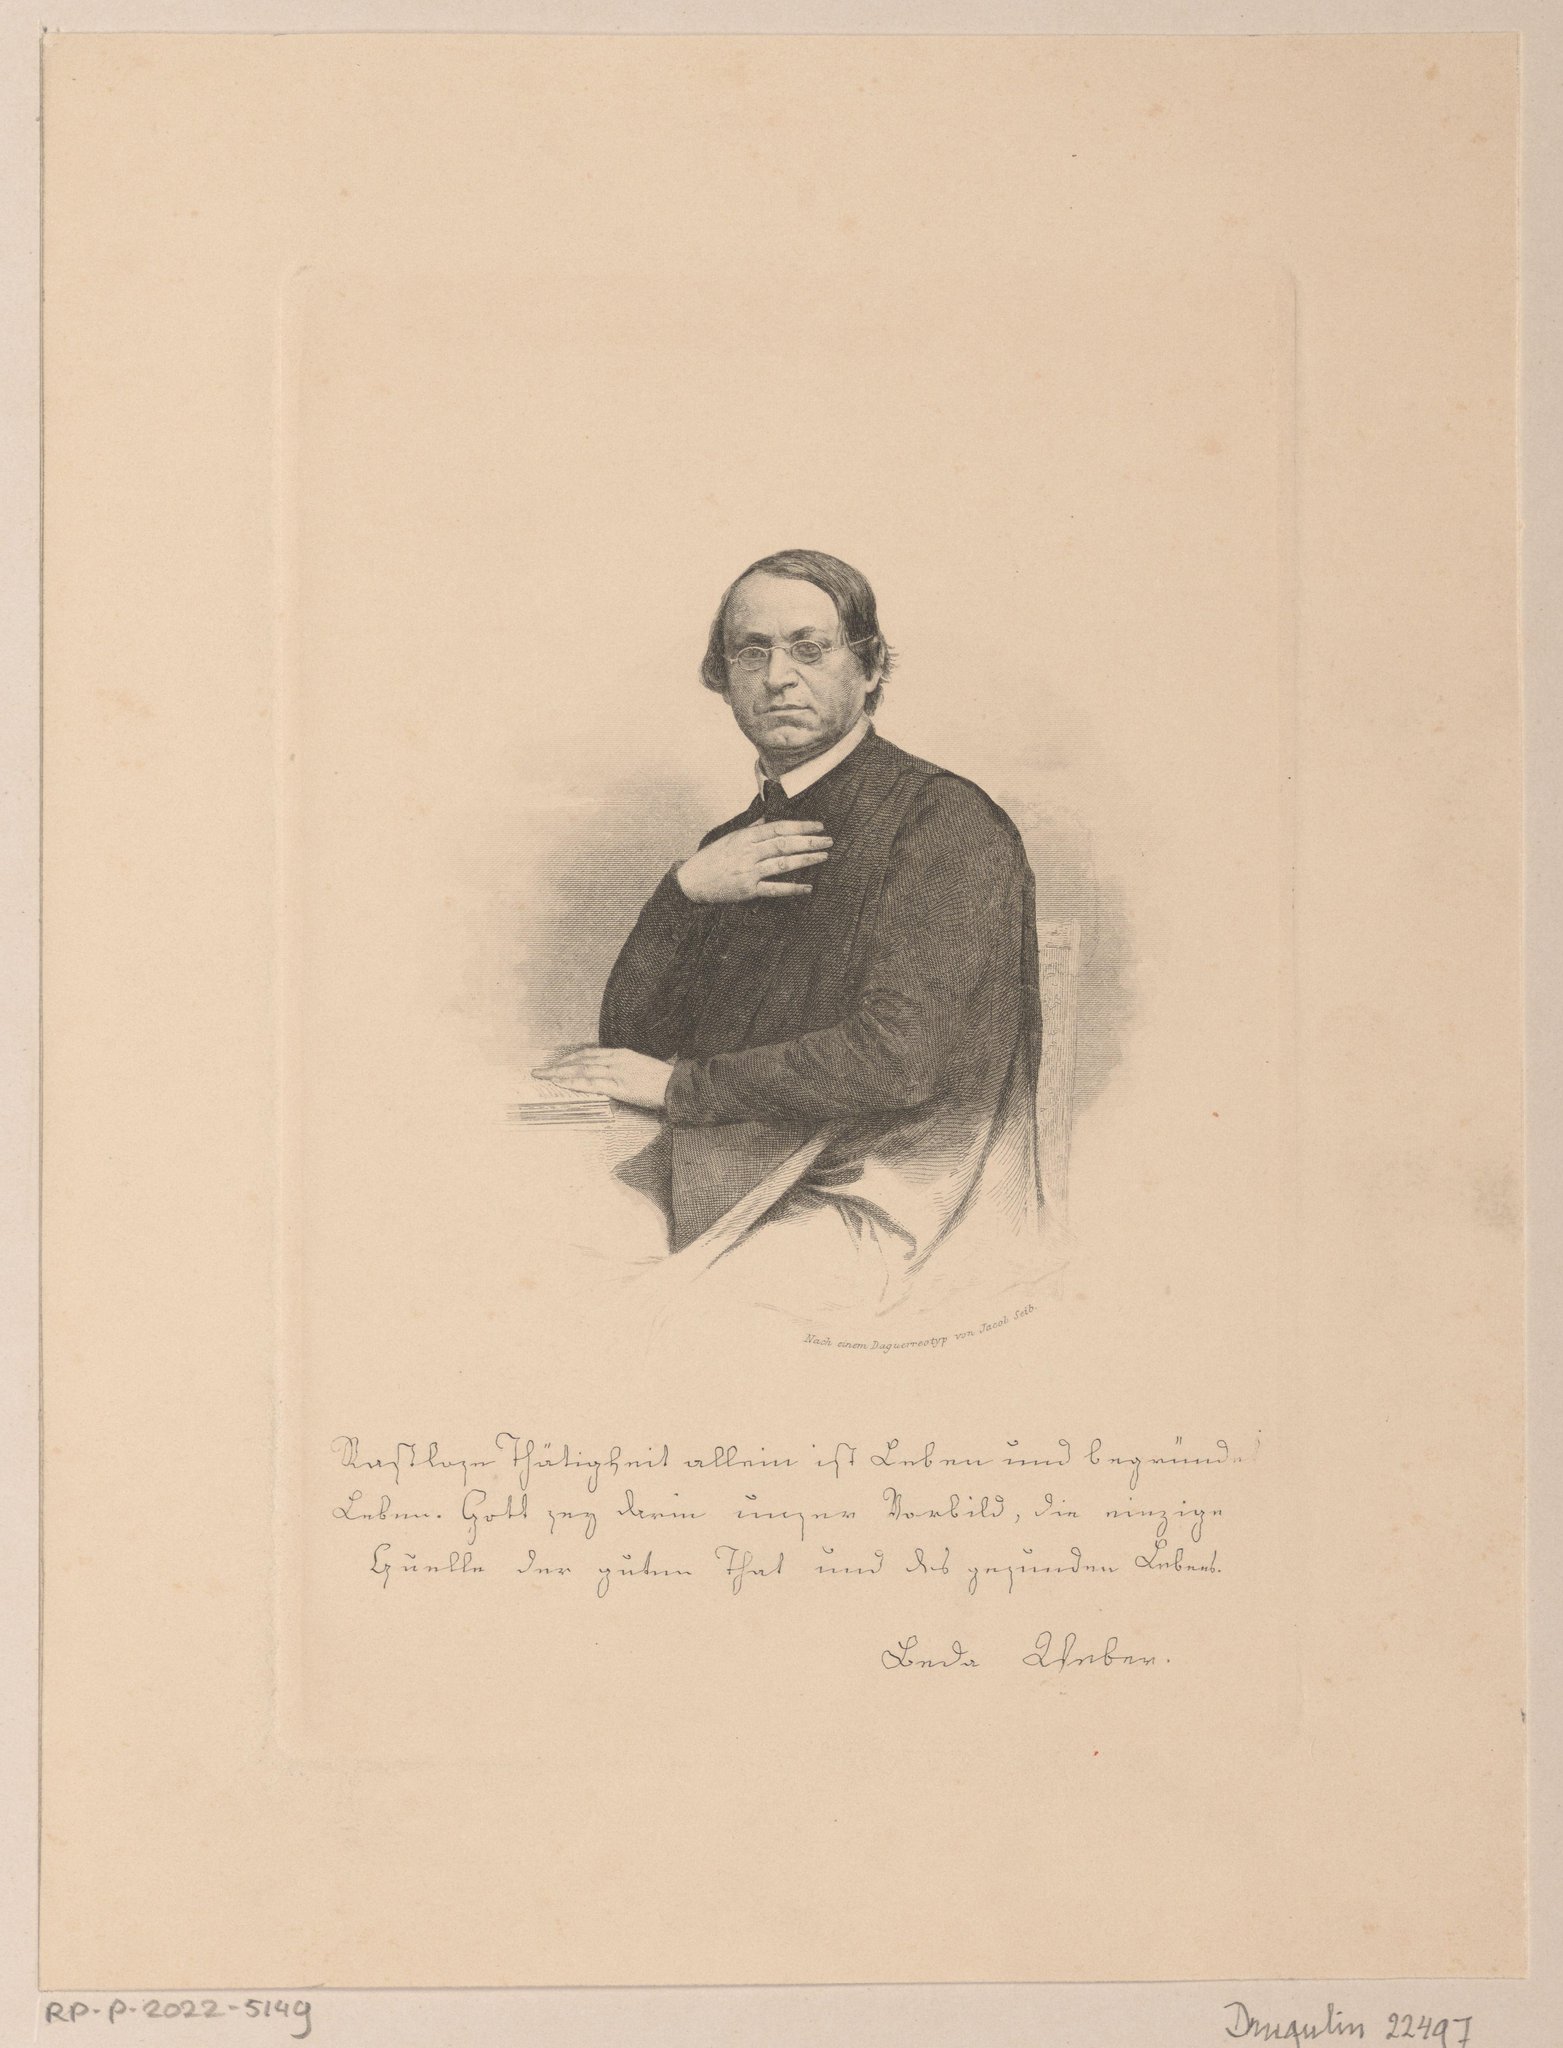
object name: print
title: Portret van Beda Weber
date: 1853-1858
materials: paper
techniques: engraving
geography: germany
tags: theologian, historical persons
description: Prent ook gebruikt in: Weber, Beda. Charakterbilder. Frankfurt am Main: J.D. Sauerländer, 1853. En later in: Weber, Beda. Lebens- und Literatur-Bild. Regensburg: Friedrich Pustet, 1858.